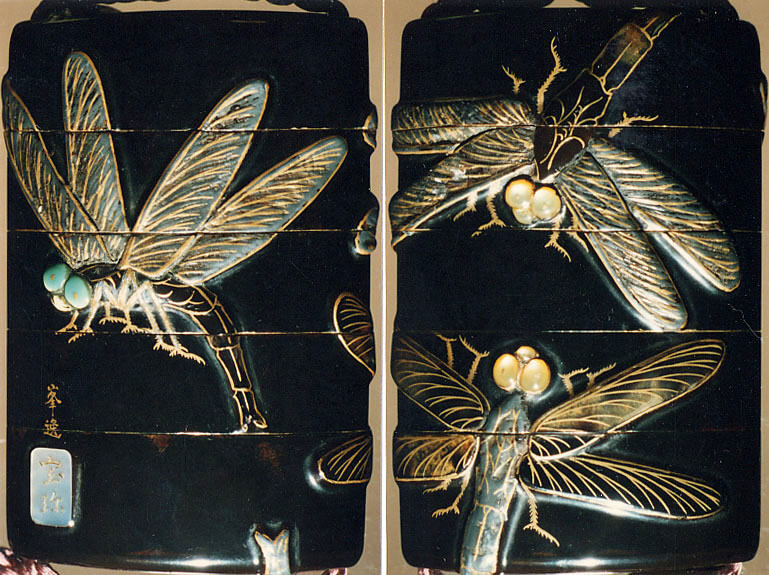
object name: inrō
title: Case (Inrō) with Design of Dragonflies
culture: japanese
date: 1701-1900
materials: ceramic, gold, lacquer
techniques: fundame, hiramakie, inlay, roiro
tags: dragonflies